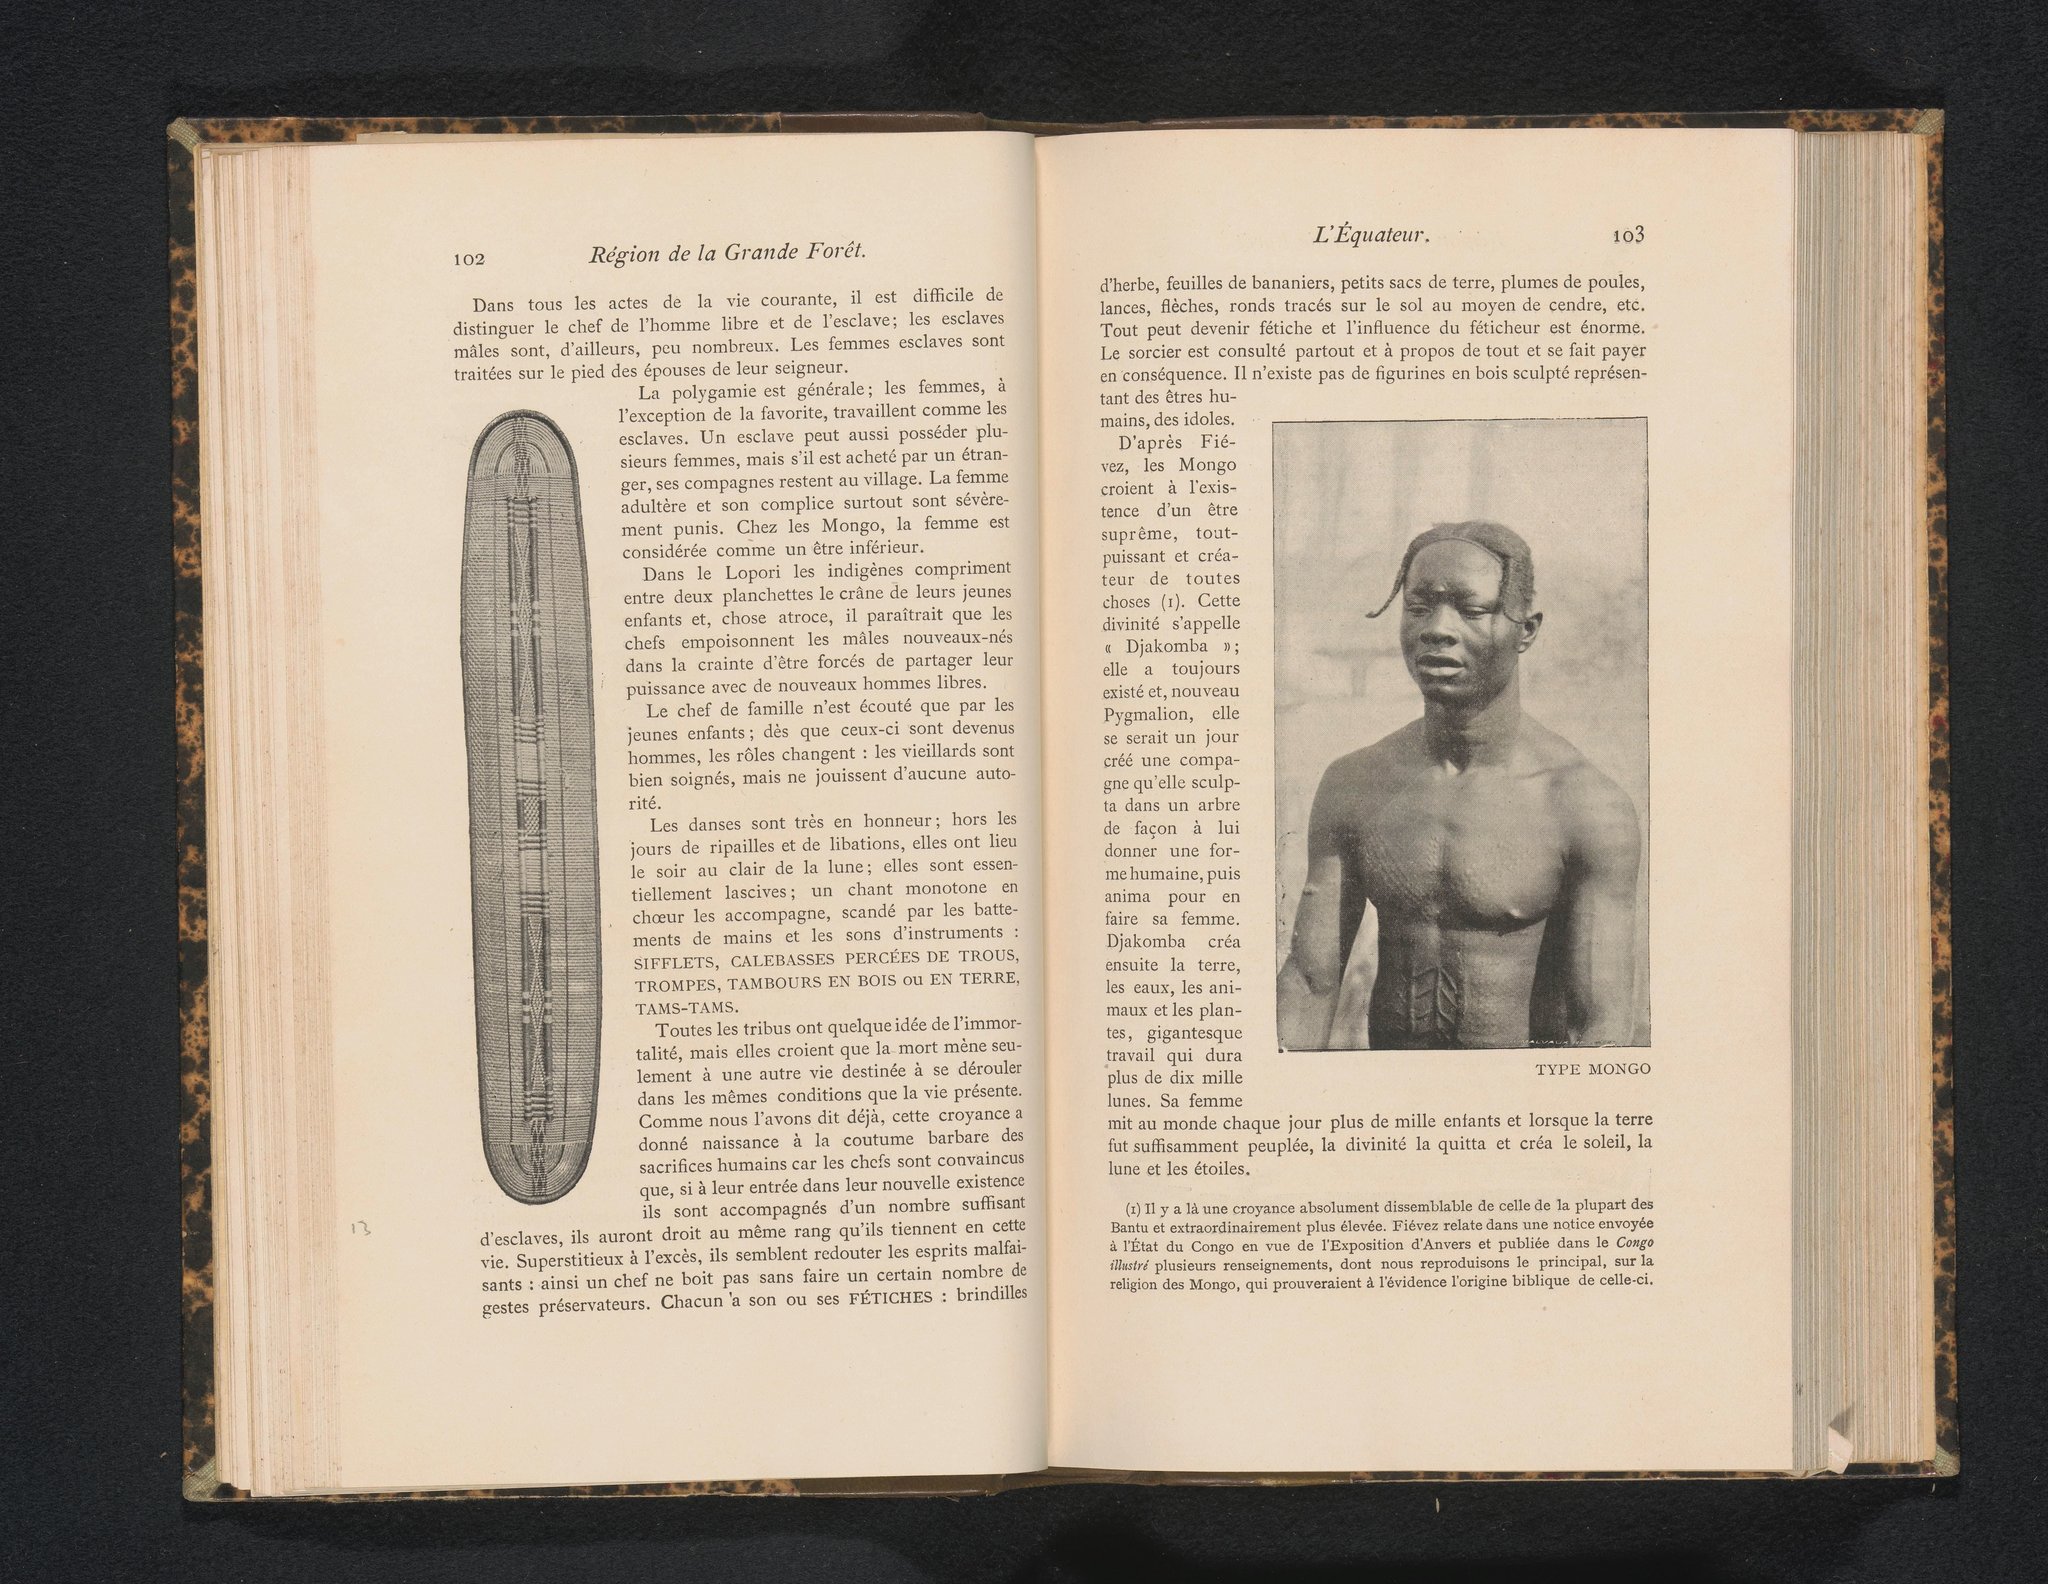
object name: page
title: Portret van een onbekende man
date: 1892-1897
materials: paper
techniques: autotype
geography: congo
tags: historical persons